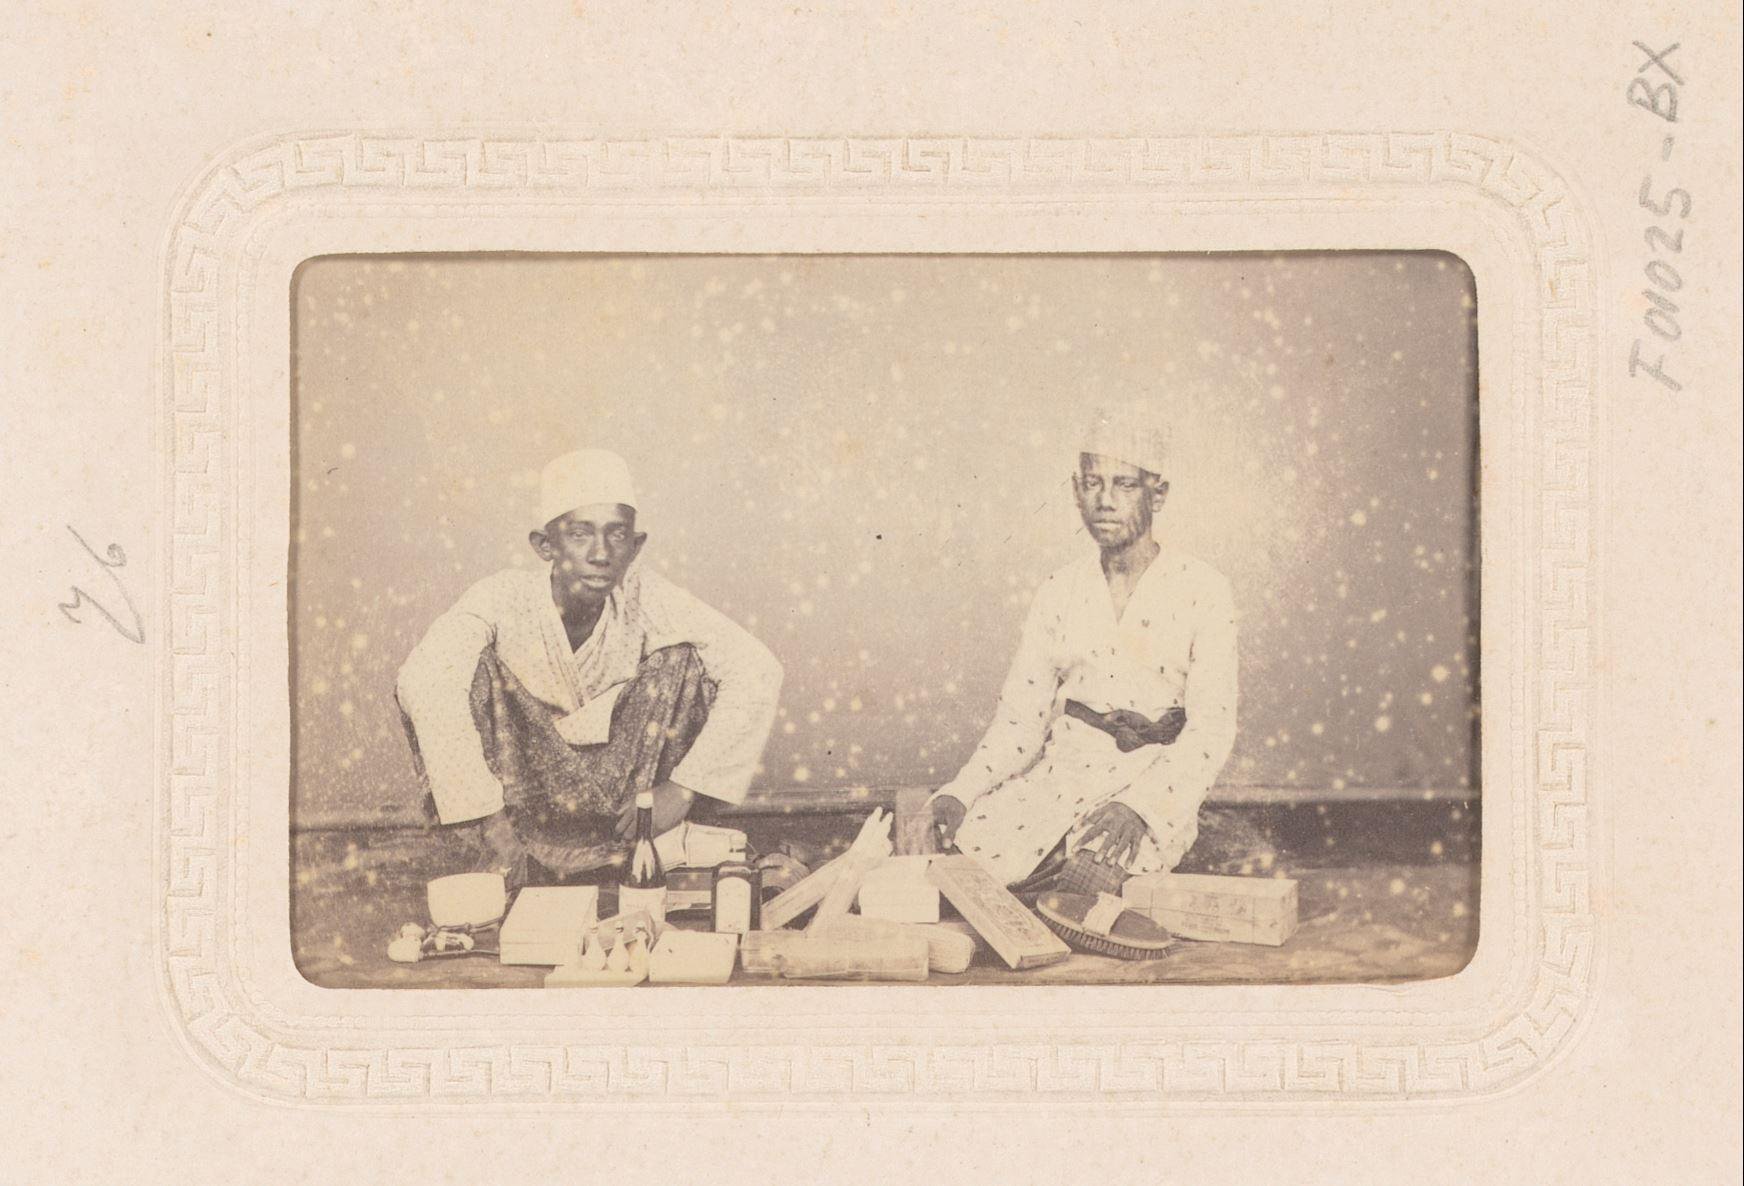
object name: album leaf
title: Twee jonge Indonesische kooplieden met koopwaren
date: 1857-1880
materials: cardboard, photographic support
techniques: albumen print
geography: java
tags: youth, adolescent, merchant, salesman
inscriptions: inscription: ‘Woodbury & Page/ Photographers/ Java’, number: ‘76’